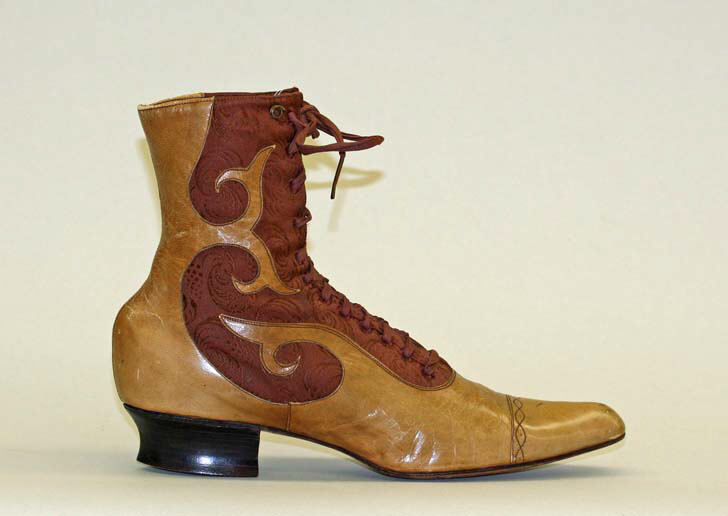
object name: shoe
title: Shoes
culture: american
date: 1899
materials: leather